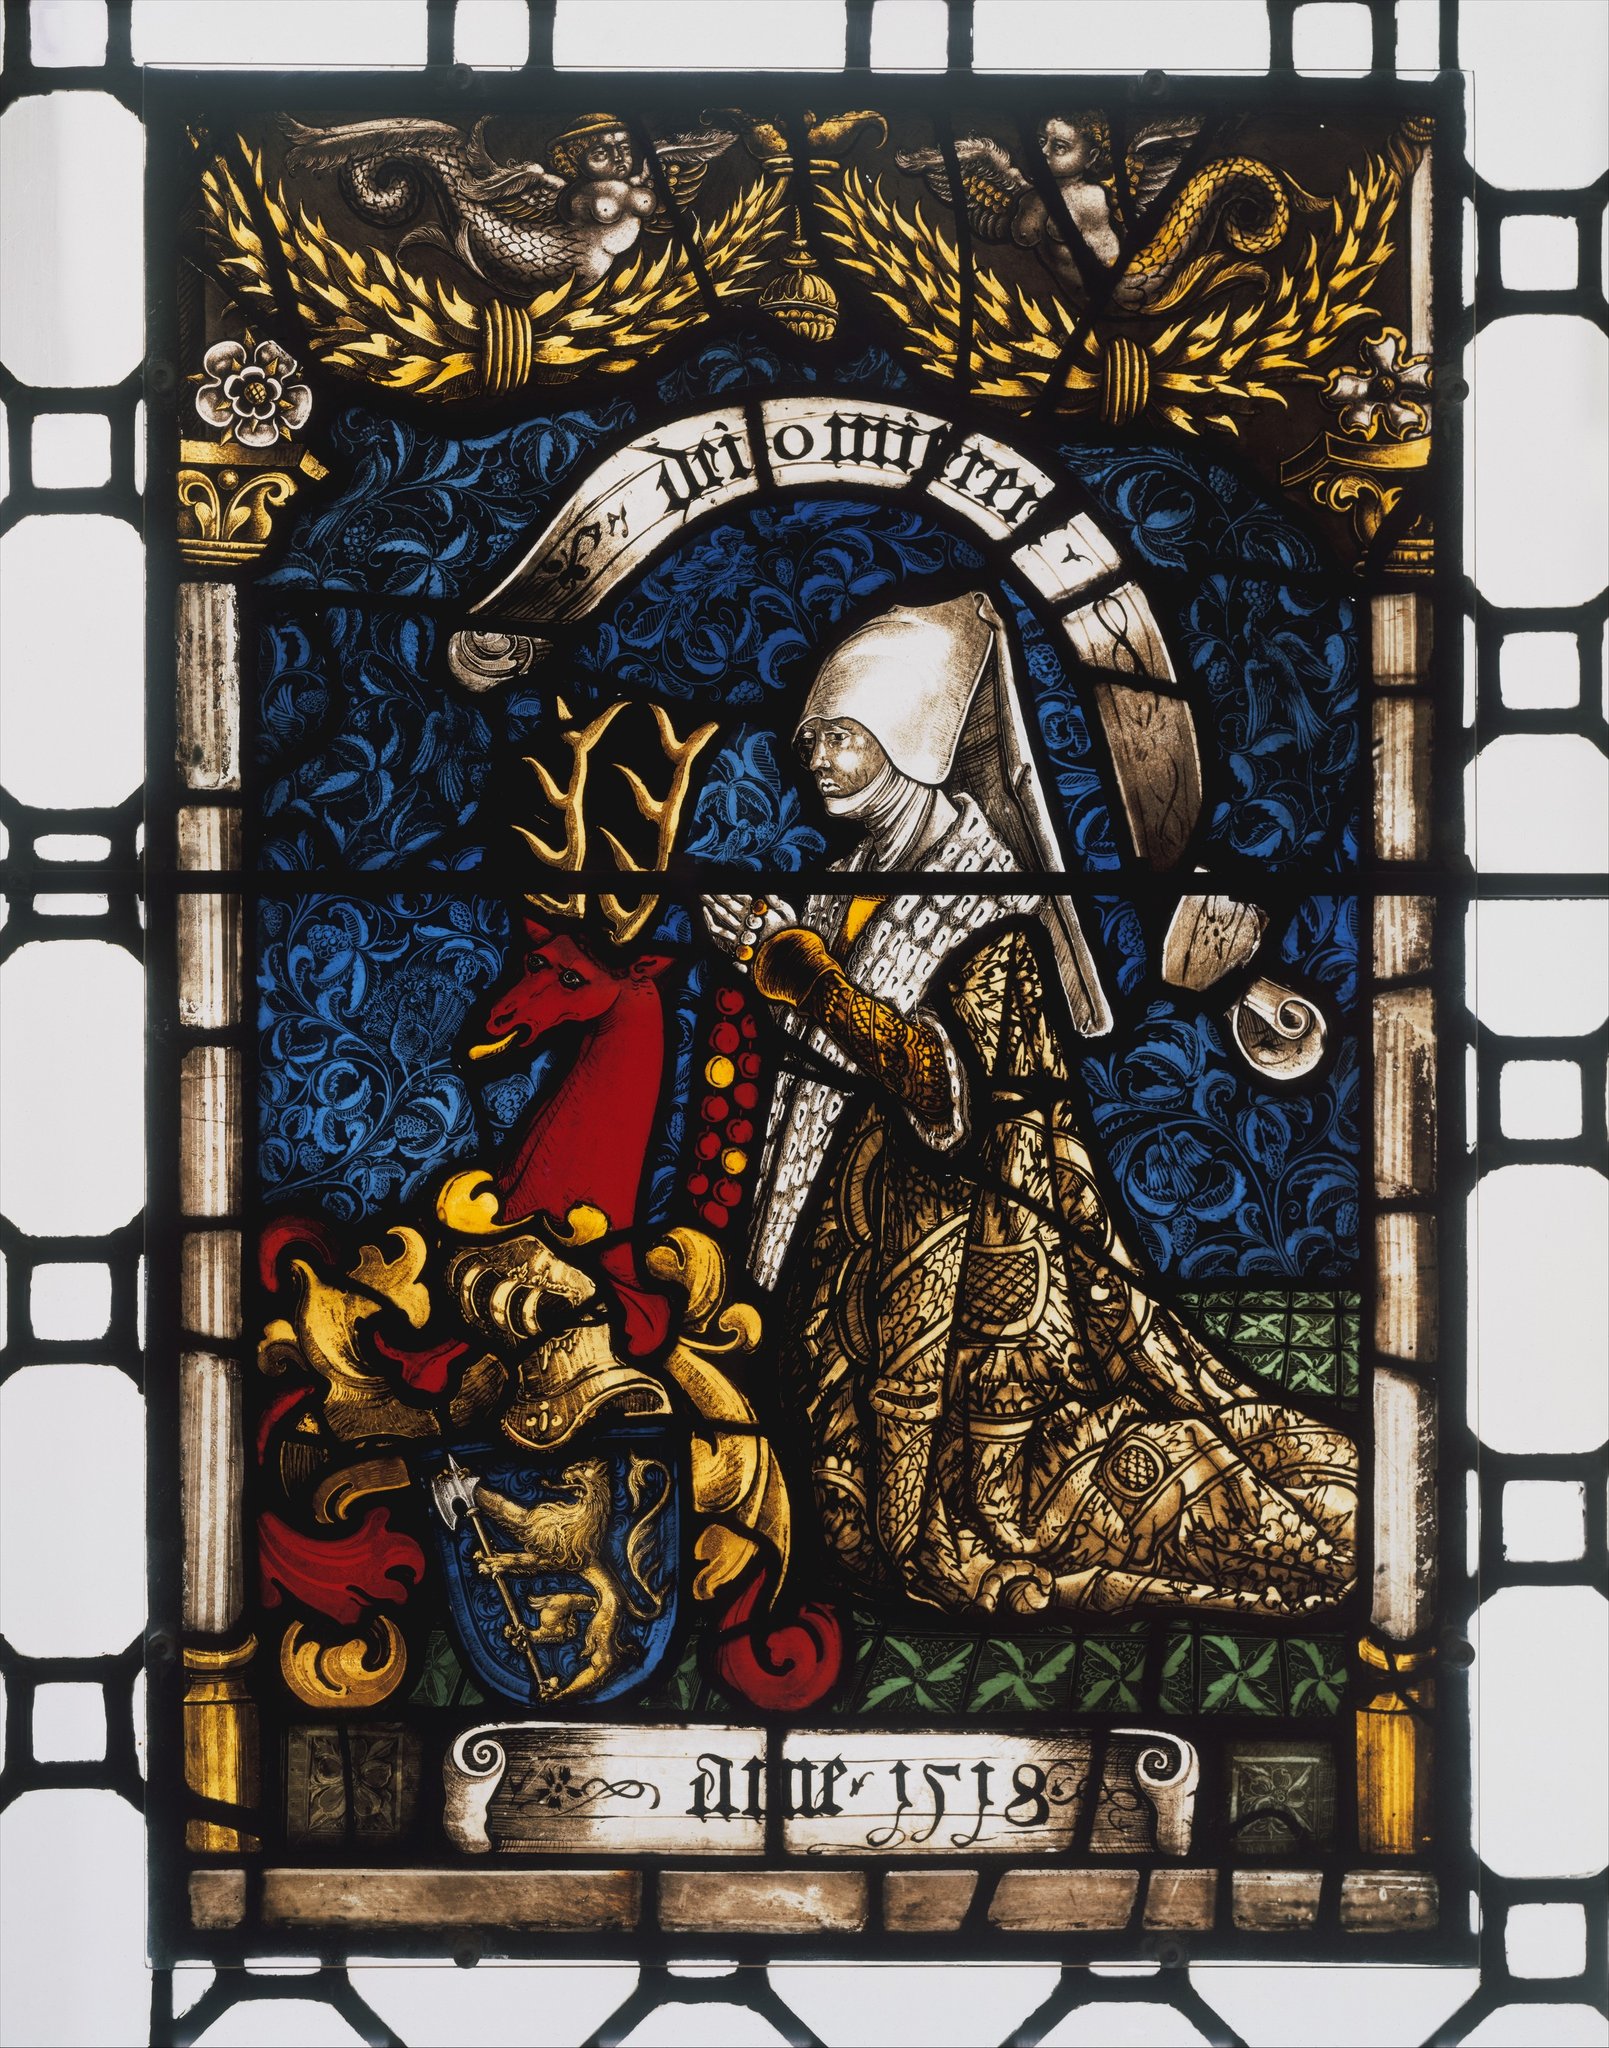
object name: panel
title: Heraldic Panel of Barbara von Zimmern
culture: german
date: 1518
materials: enamel, glass, metal, paint, pigment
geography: germany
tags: women,coat of arms